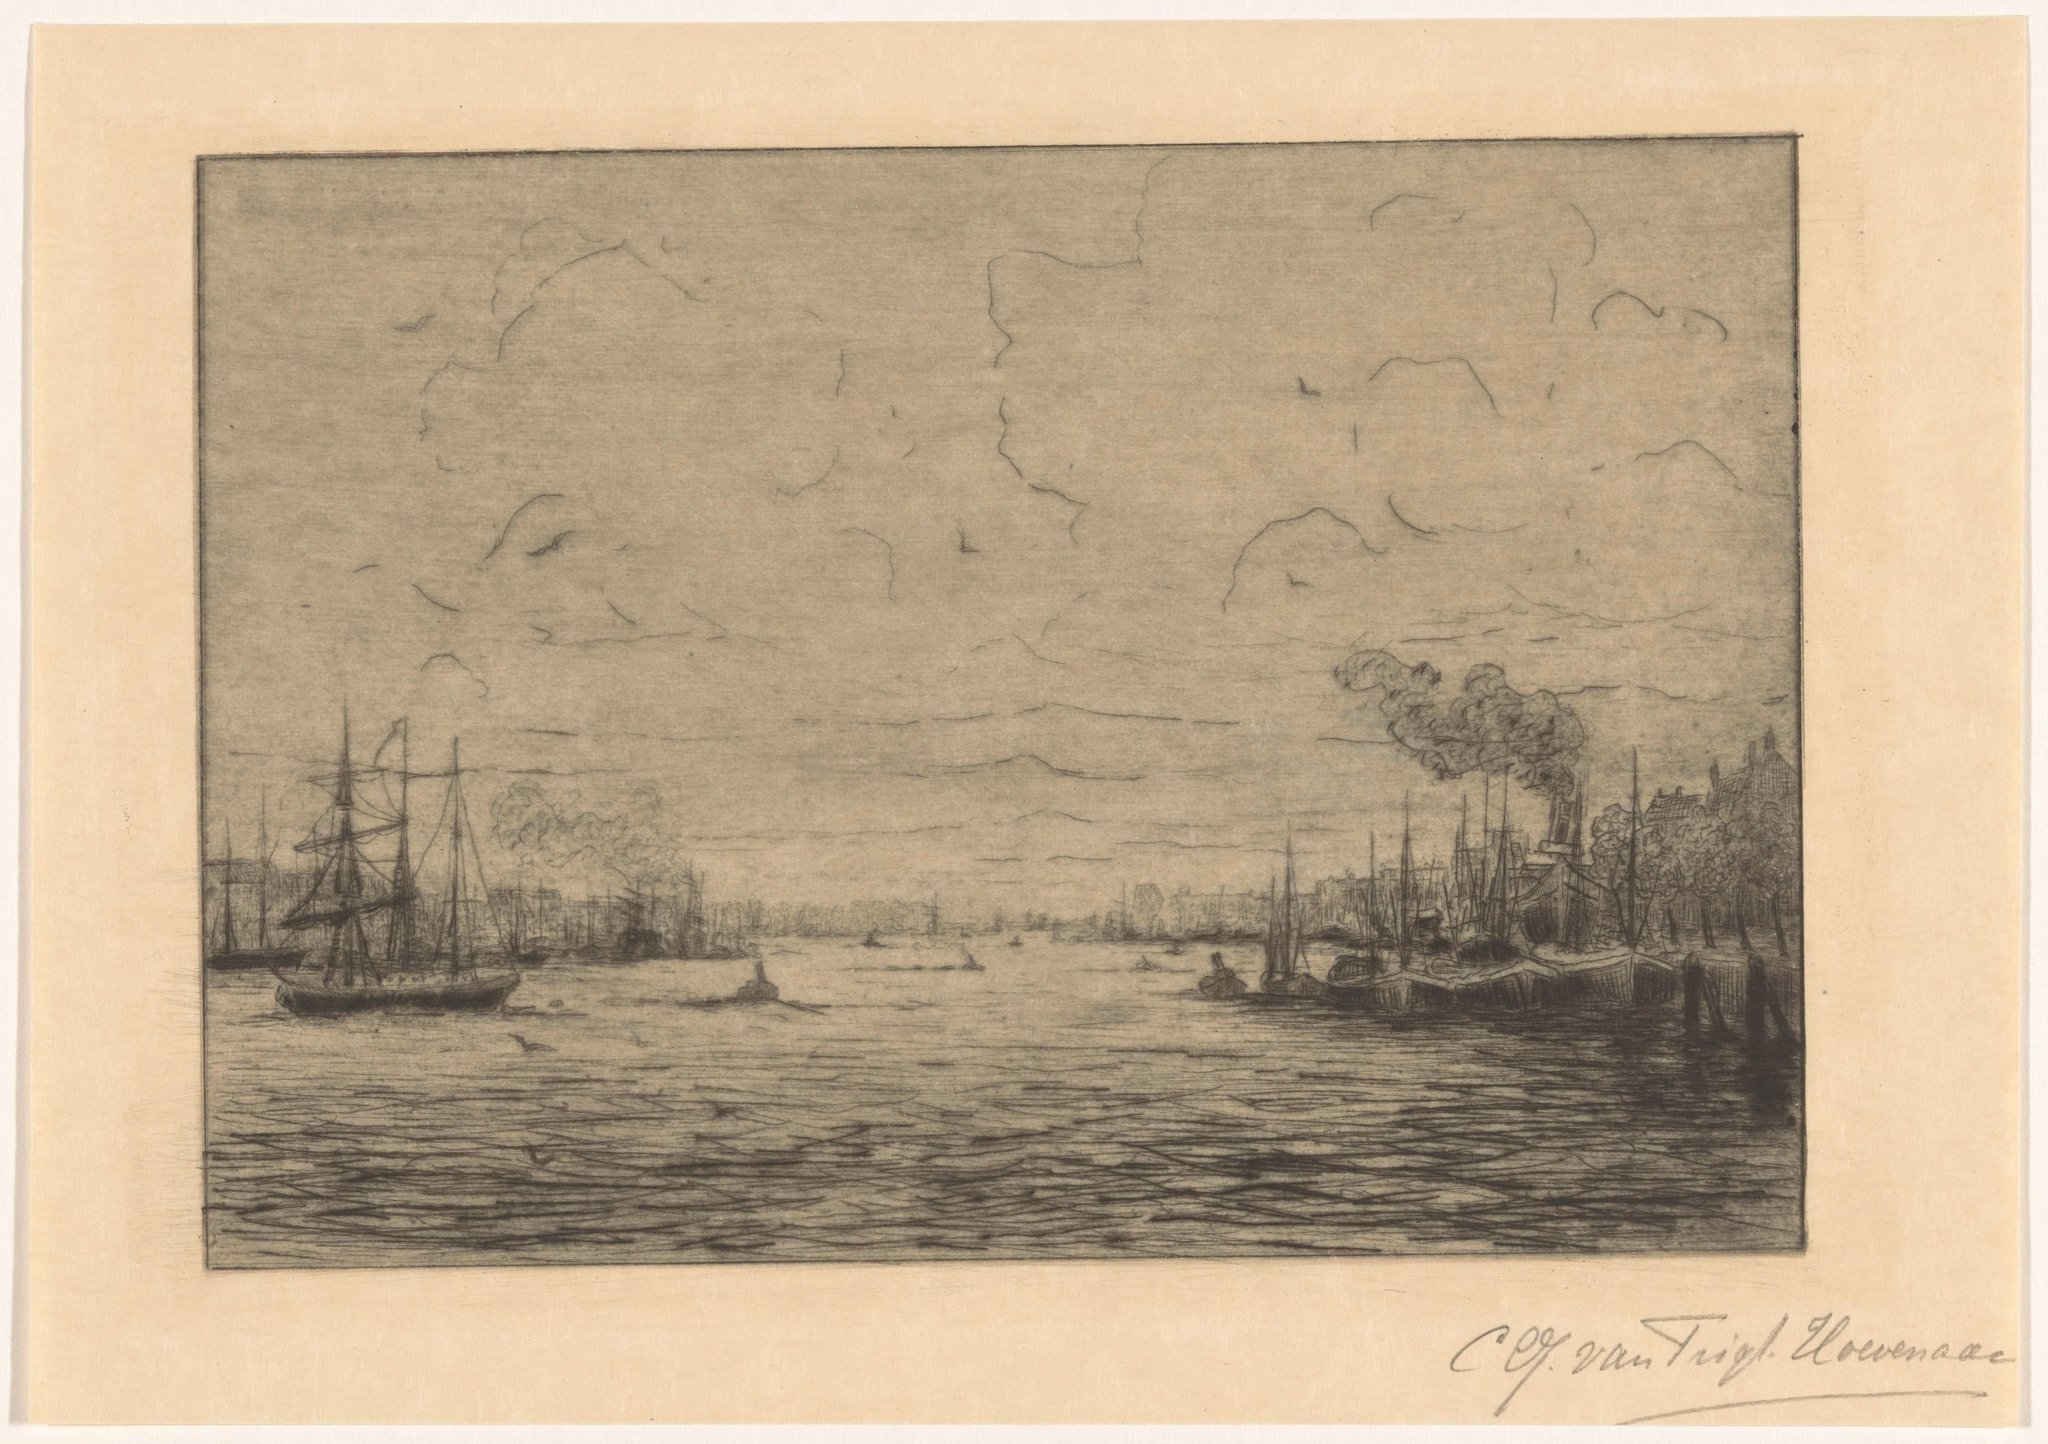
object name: print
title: Gezicht op de Maas bij Rotterdam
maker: cornelia christina johanna van trigt-hoevenaar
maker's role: print maker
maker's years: 1854-1924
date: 1864-1910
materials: paper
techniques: drypoint, intaglio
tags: harbour, rotterdam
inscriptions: collector's mark: Lugt 2228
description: Rechts een stoomboot; links een zeilschip.